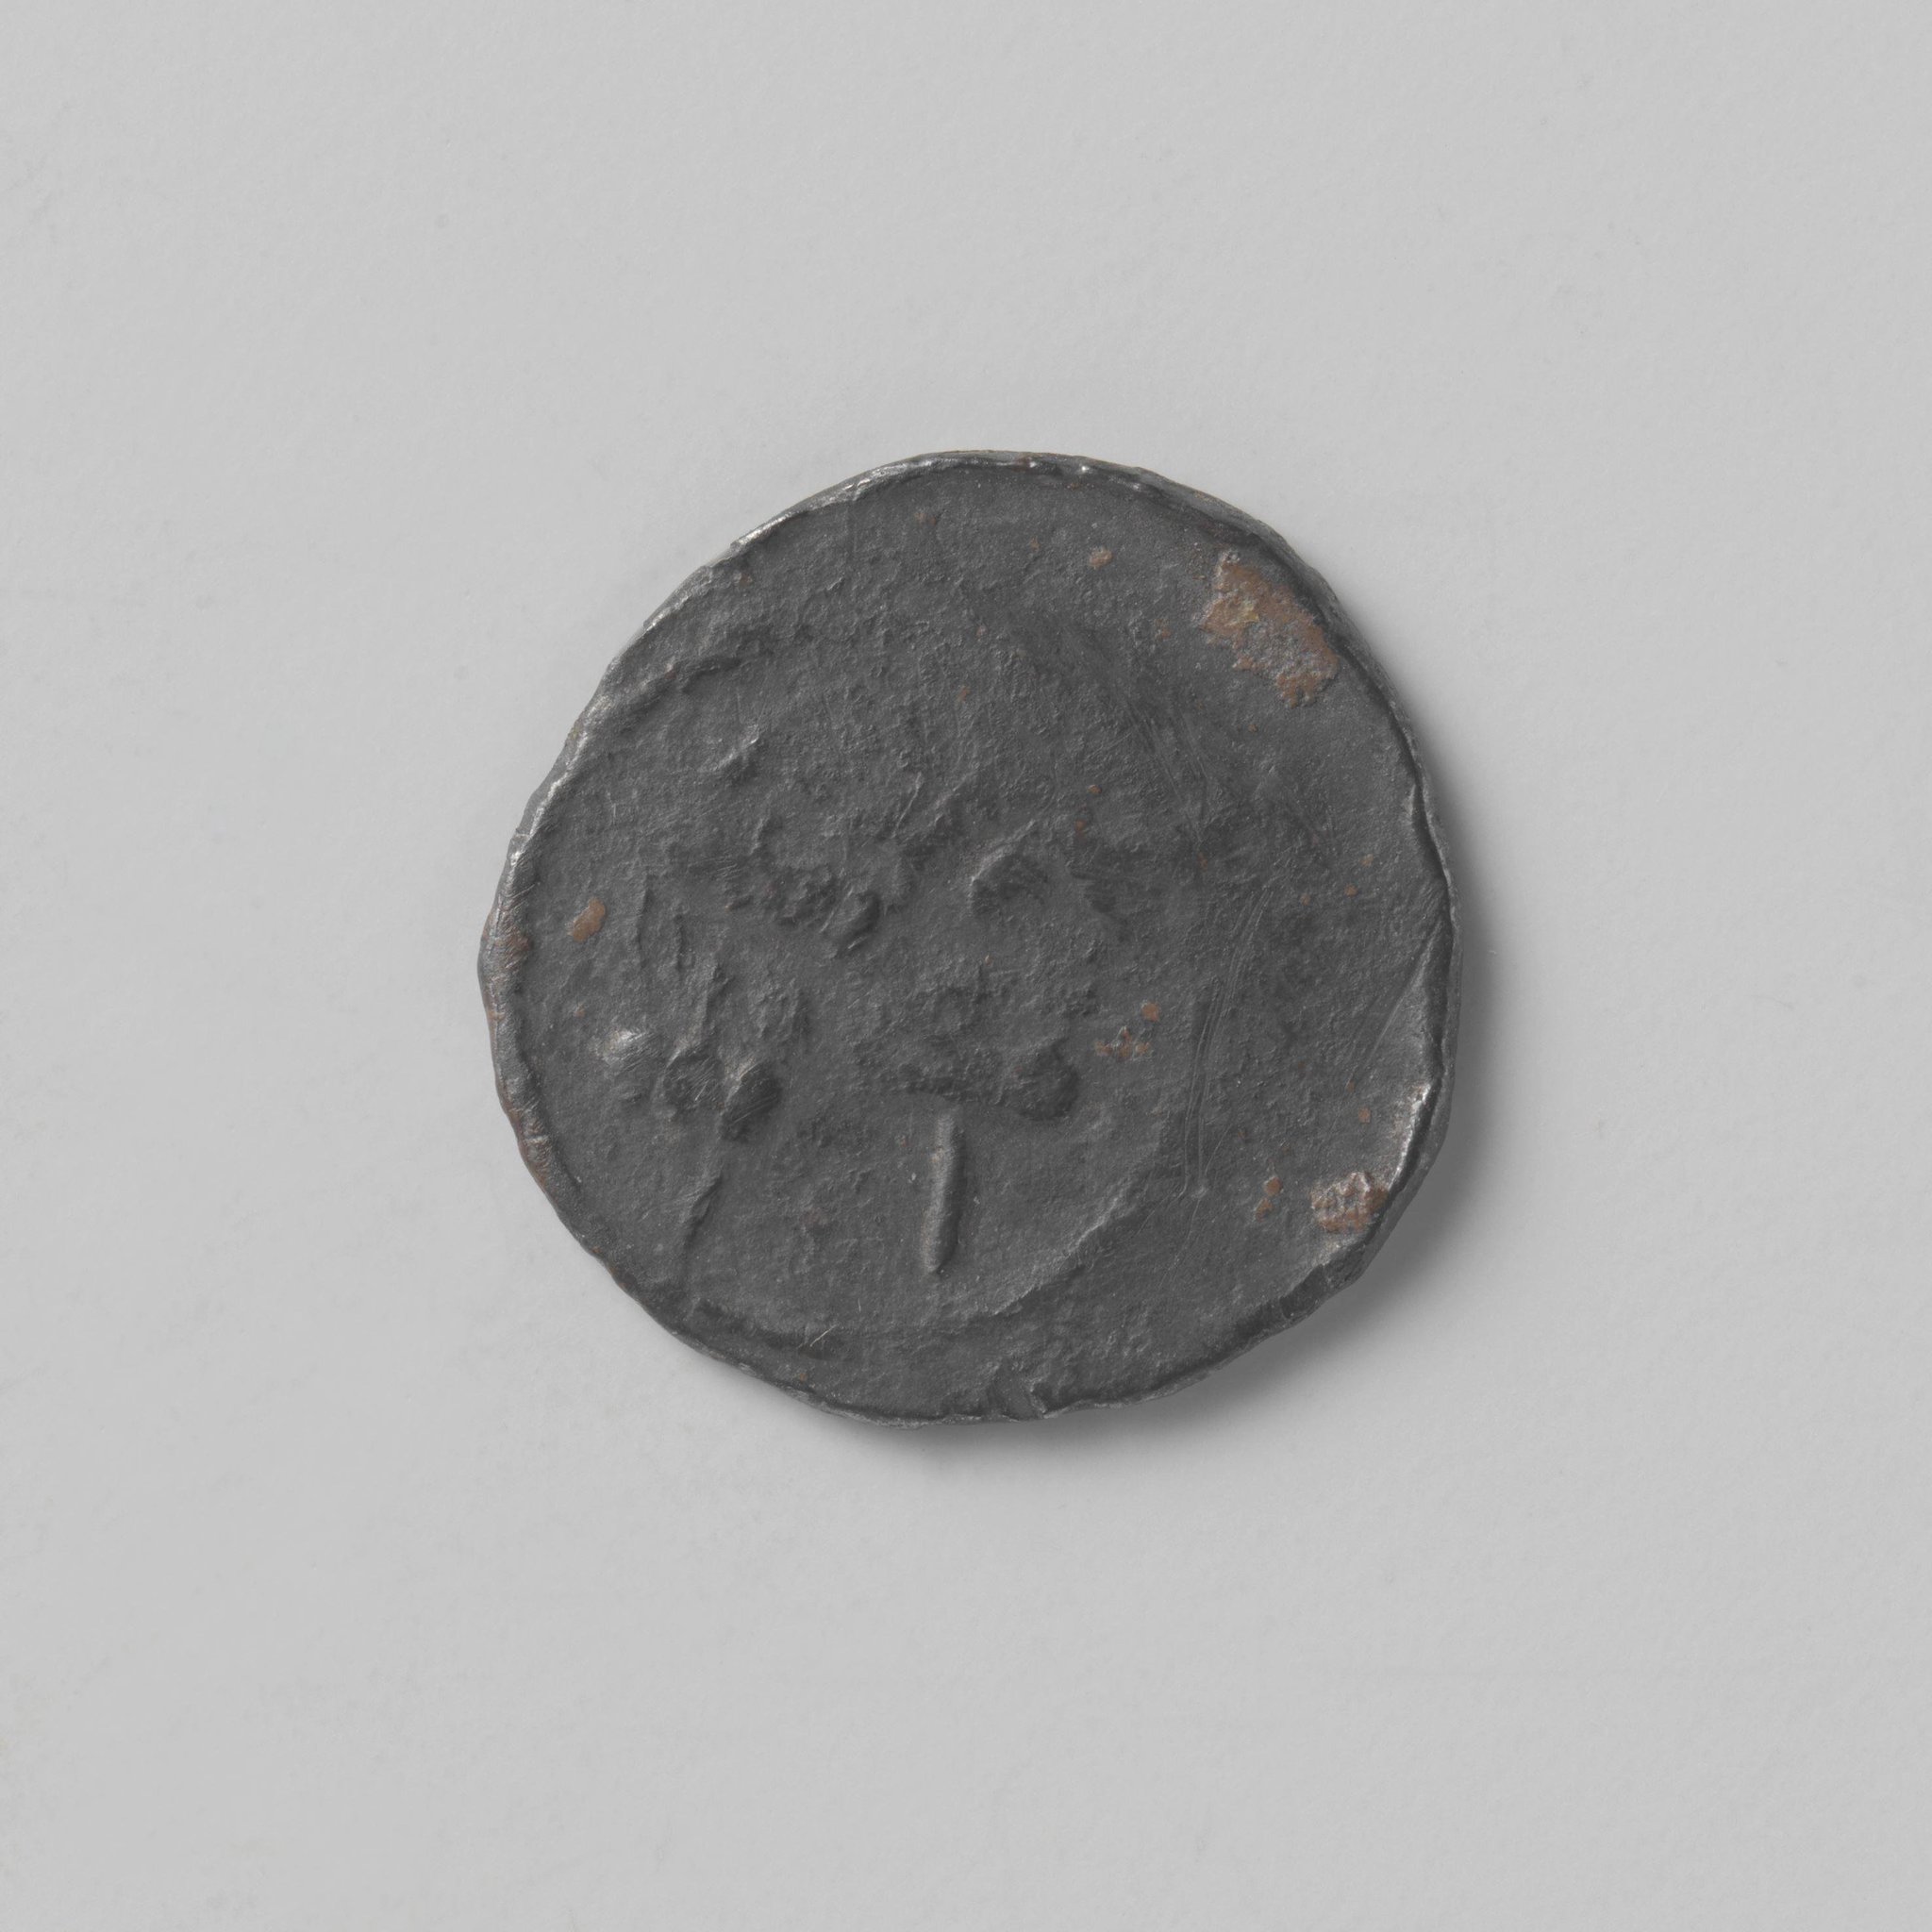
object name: penny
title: Holland, Floris V, penning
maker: floris v (graaf van holland en zeeland)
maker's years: 1254-1296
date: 1256-1258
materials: silver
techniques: striking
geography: dordrecht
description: Zilveren munt. Voorzijde: hoofd met gravenmuts naar rechts. Keerzijde: lang dubbellijnig kruis.